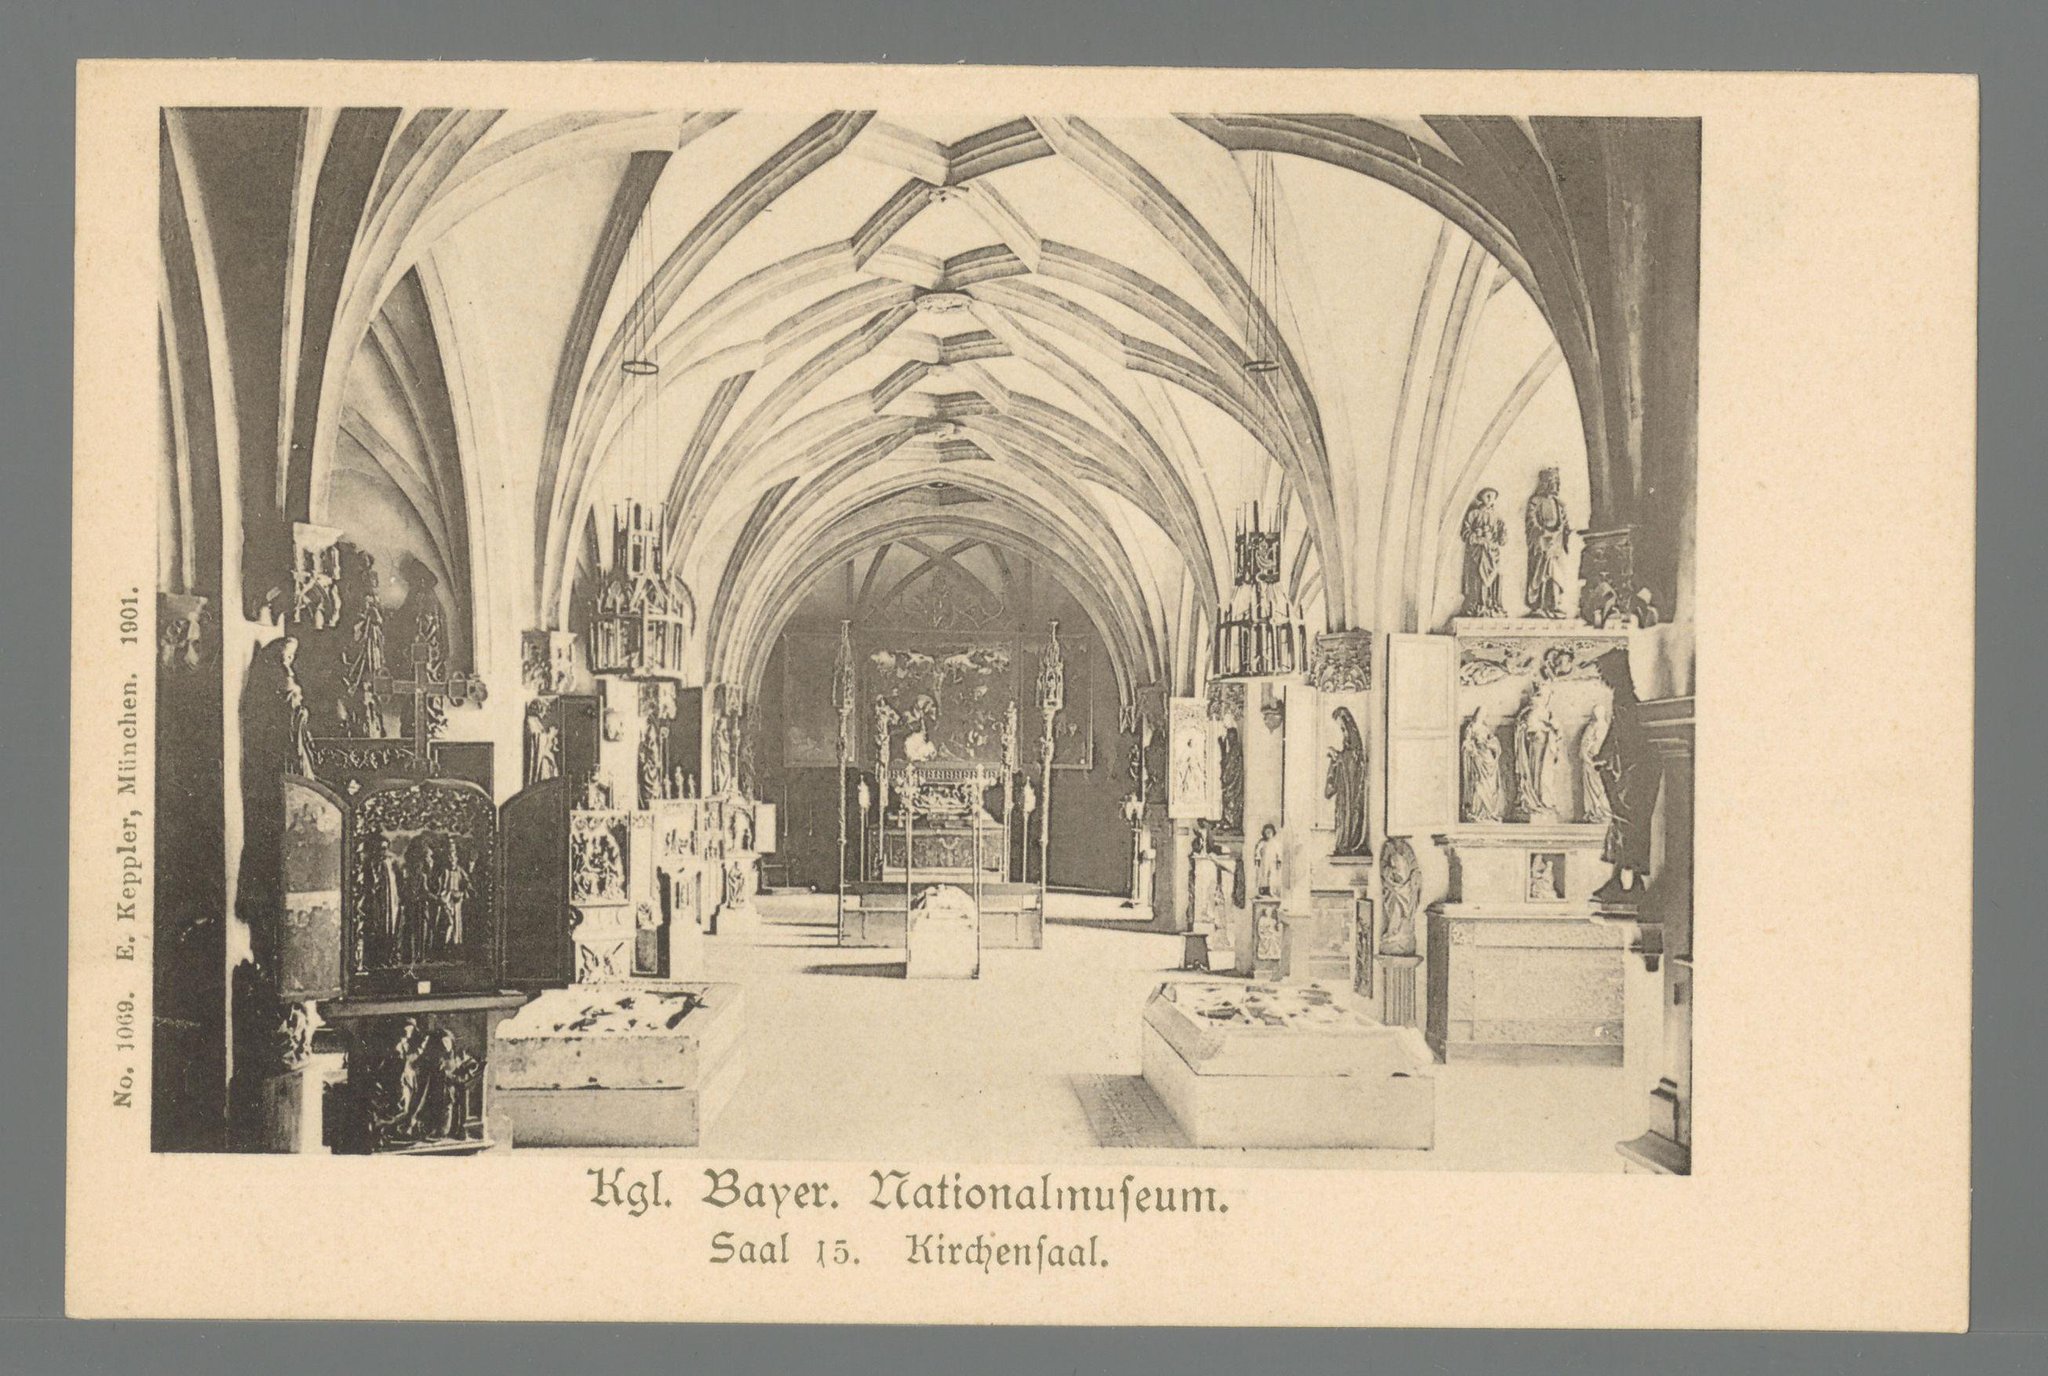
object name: photomechanical print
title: Kgl. Bayer. Nationalmuseum. Saal 15. Kirchensaal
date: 1901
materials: cardboard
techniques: photograph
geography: munich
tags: permanent exhibition, museum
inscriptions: date